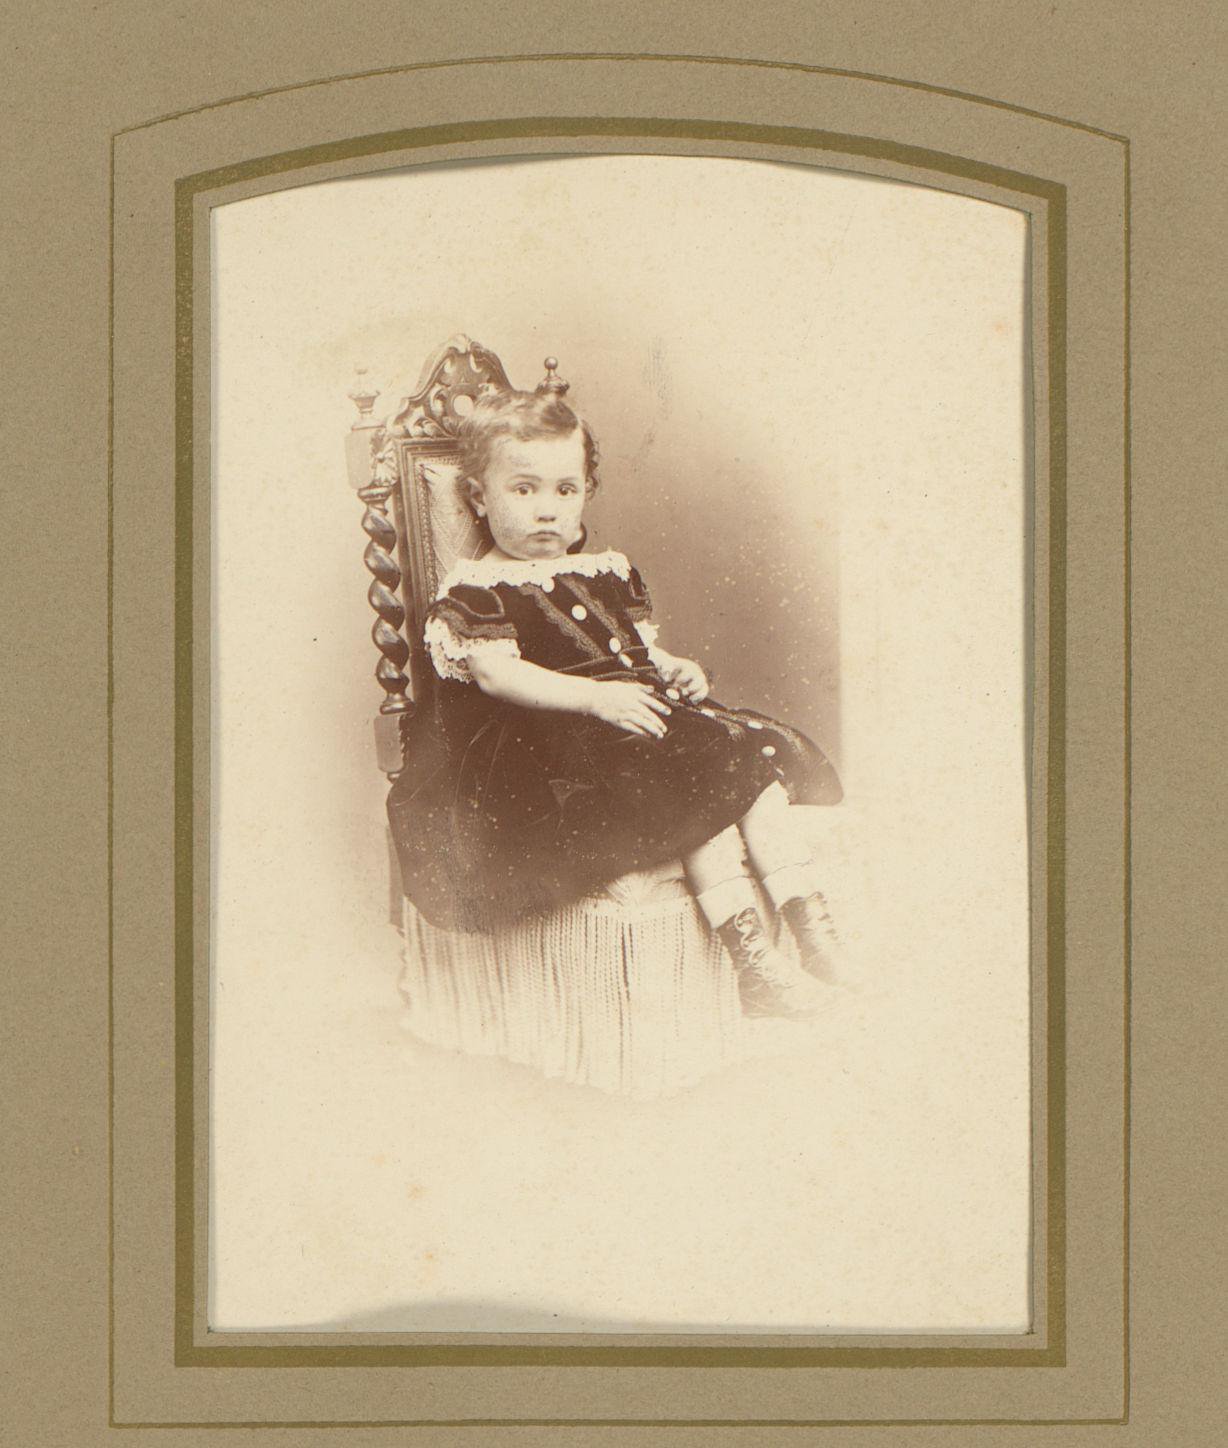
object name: photograph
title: Portret van een meisje op een stoel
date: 1862-1900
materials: cardboard, photographic support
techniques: albumen print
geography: netherlands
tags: historical persons - bb - woman, girl (child between toddler and youth), chair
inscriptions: inscription: ‘Photogr. Atelier/ WEGNER & MOTTU/ Kalverstraat/ over den Heyligenweg D 26/ AMSTERDAM.’